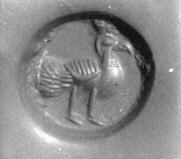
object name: stamp seal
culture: sasanian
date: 201-700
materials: stone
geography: iran or mesopotamia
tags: peacocks